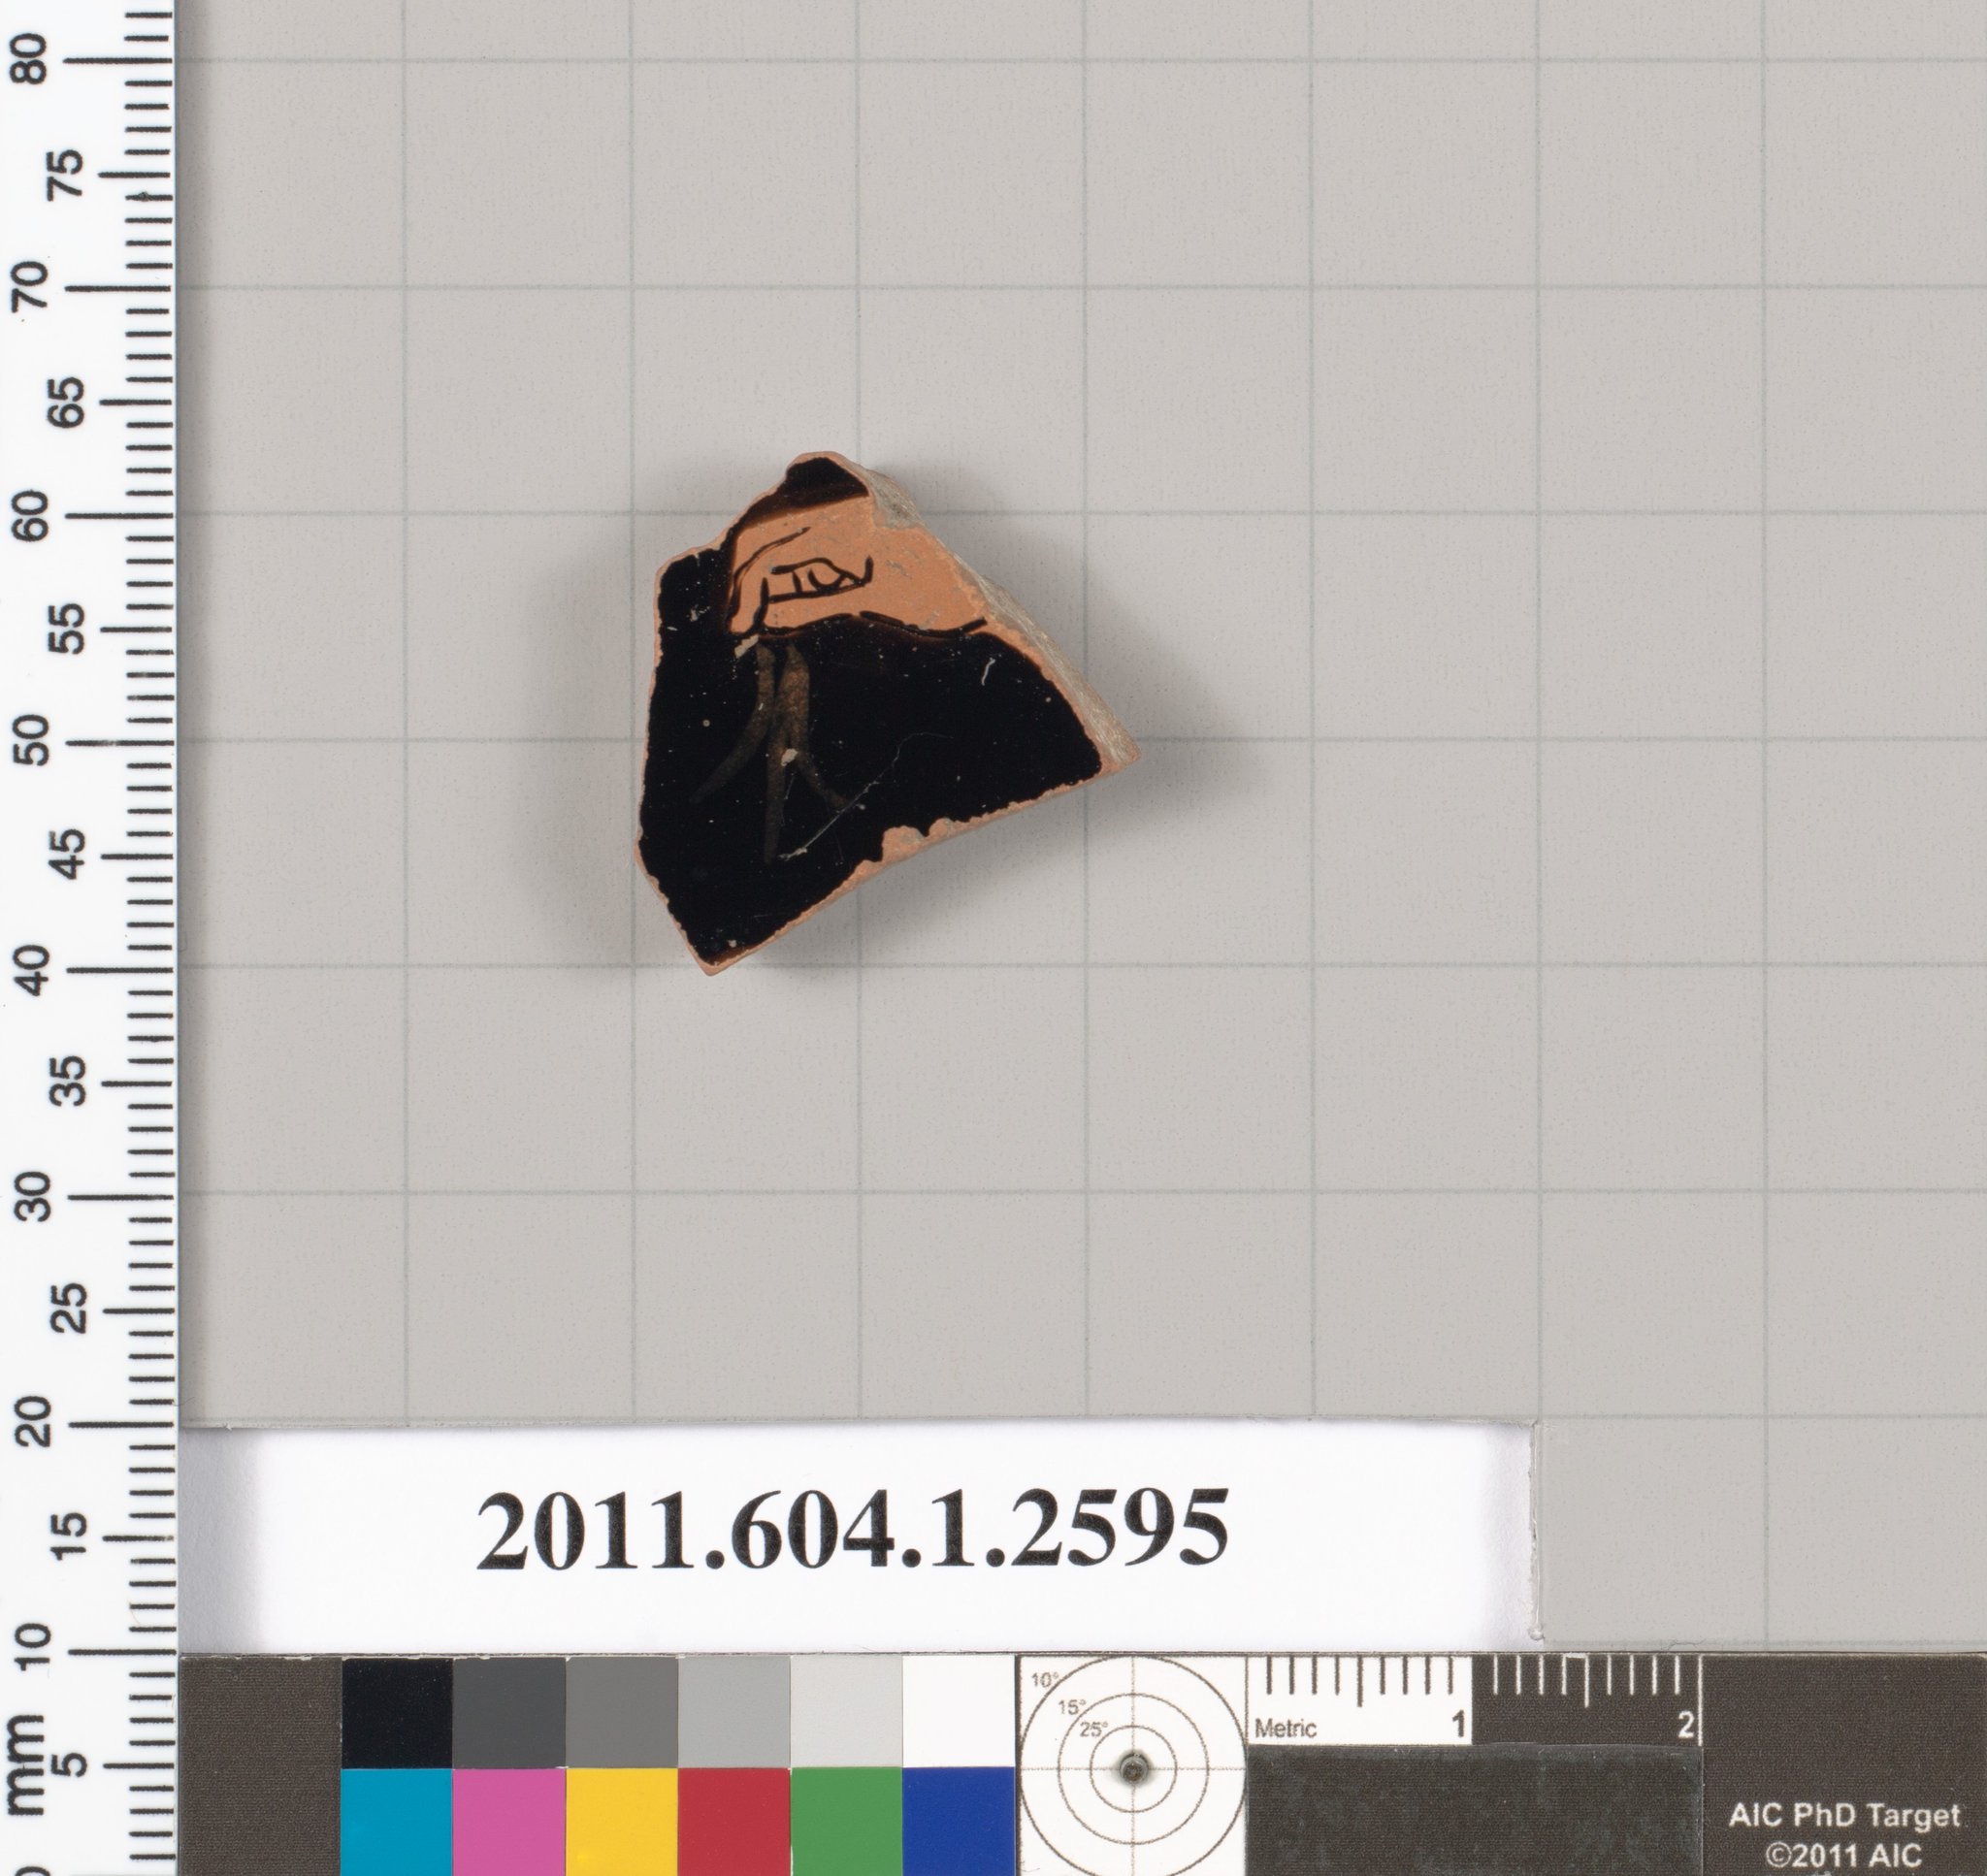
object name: kylix fragment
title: Terracotta fragment of a kylix (drinking cup)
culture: greek, attic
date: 490-480 BCE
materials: terracotta